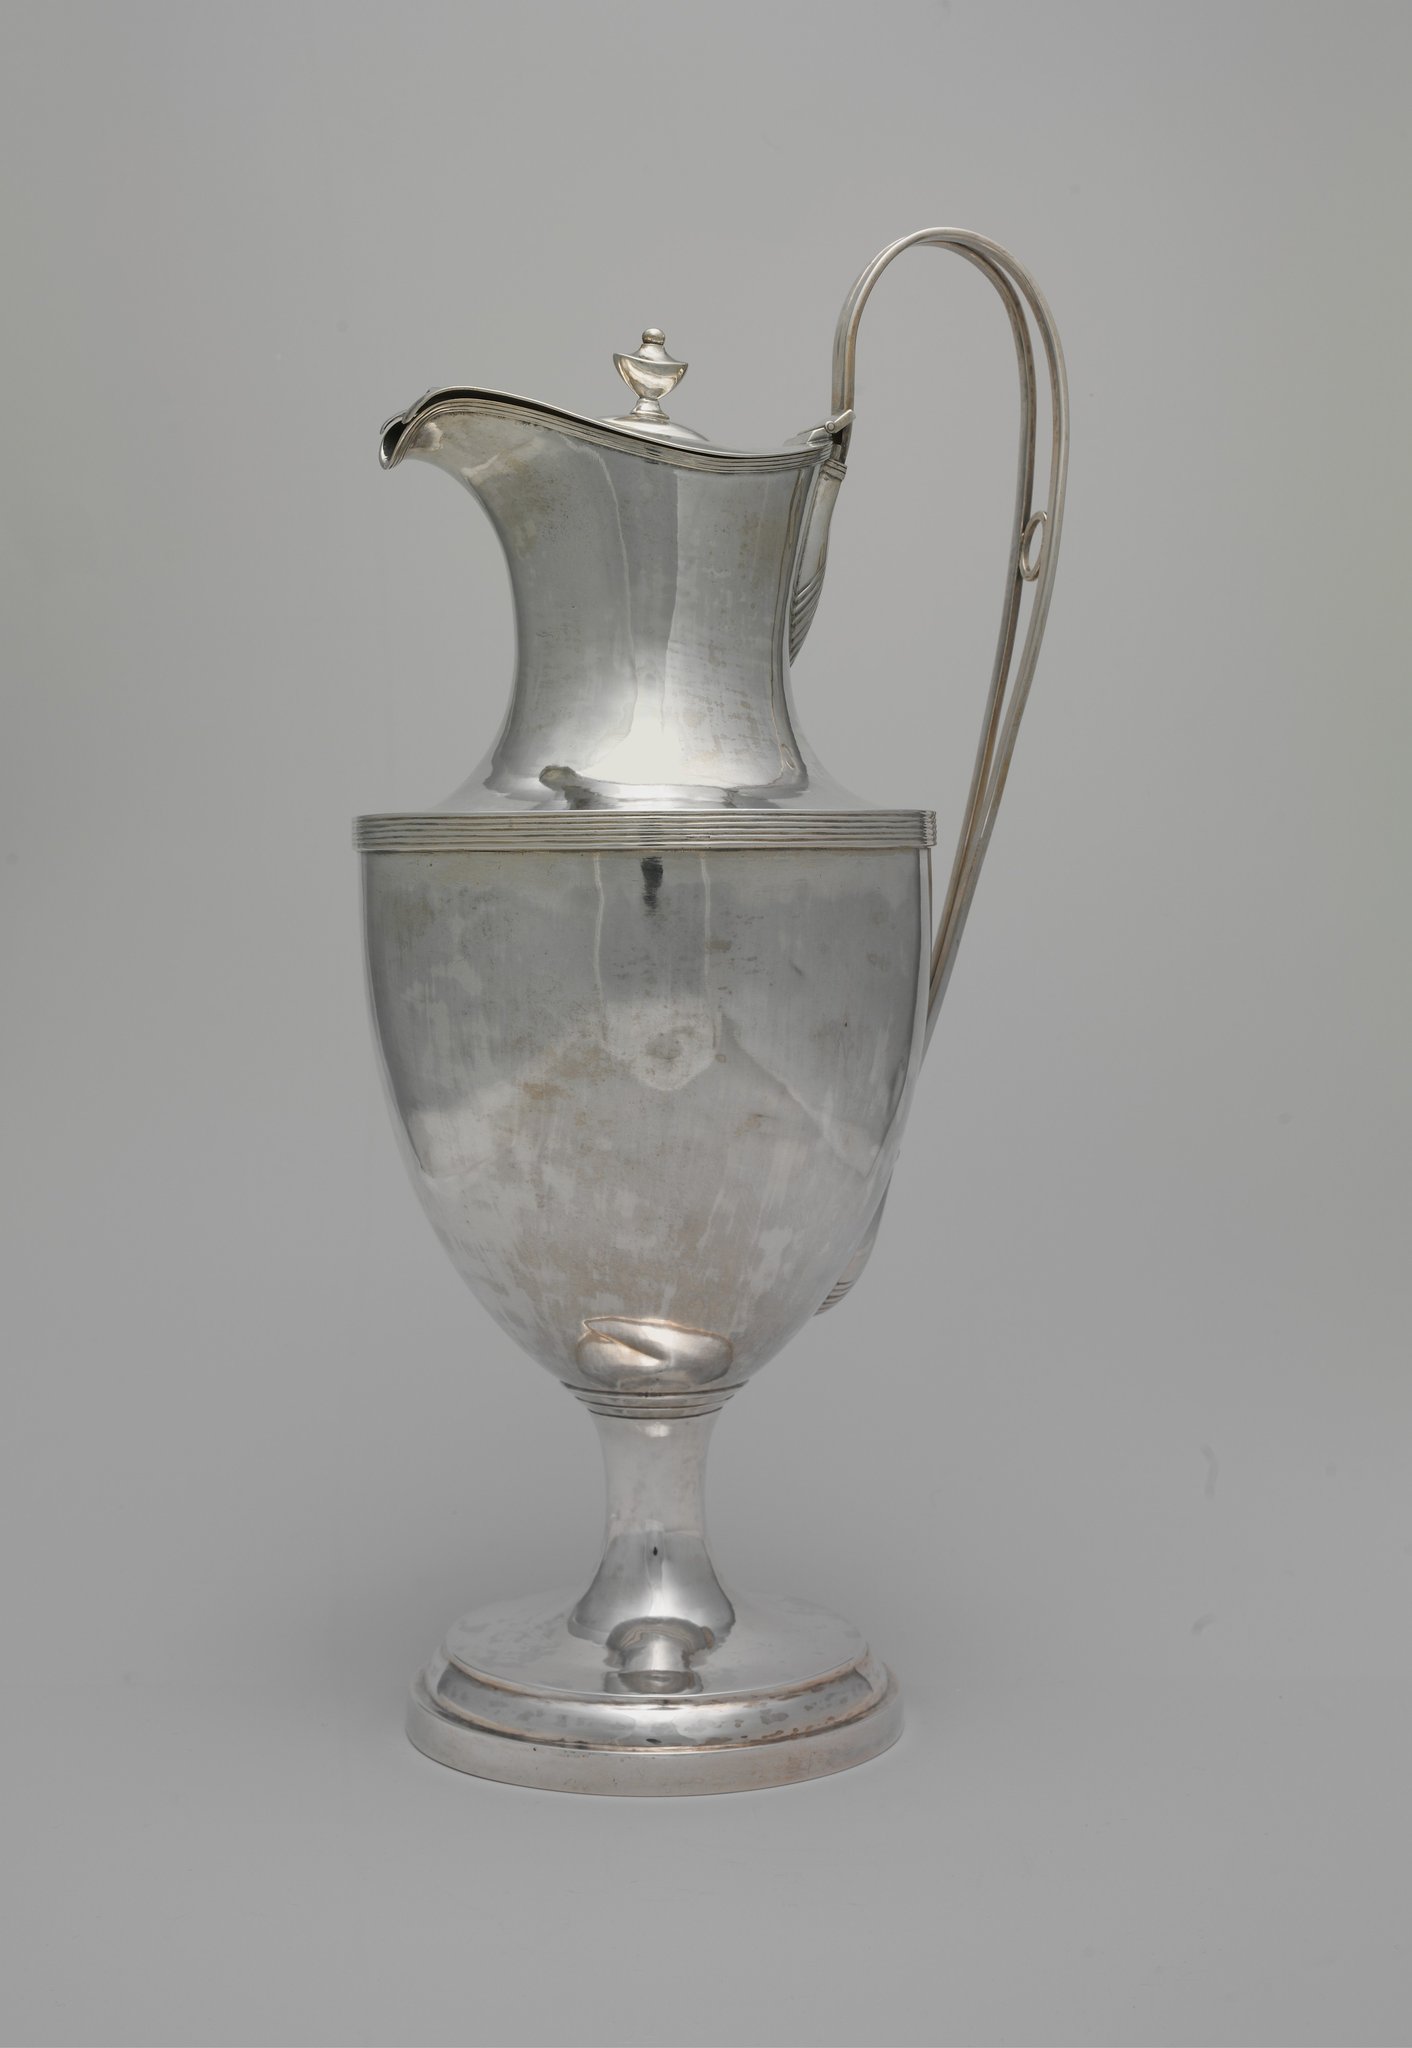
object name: flagon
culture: american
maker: rufus farnam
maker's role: maker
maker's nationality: american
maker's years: 1793-1833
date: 1800-1830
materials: silver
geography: united states